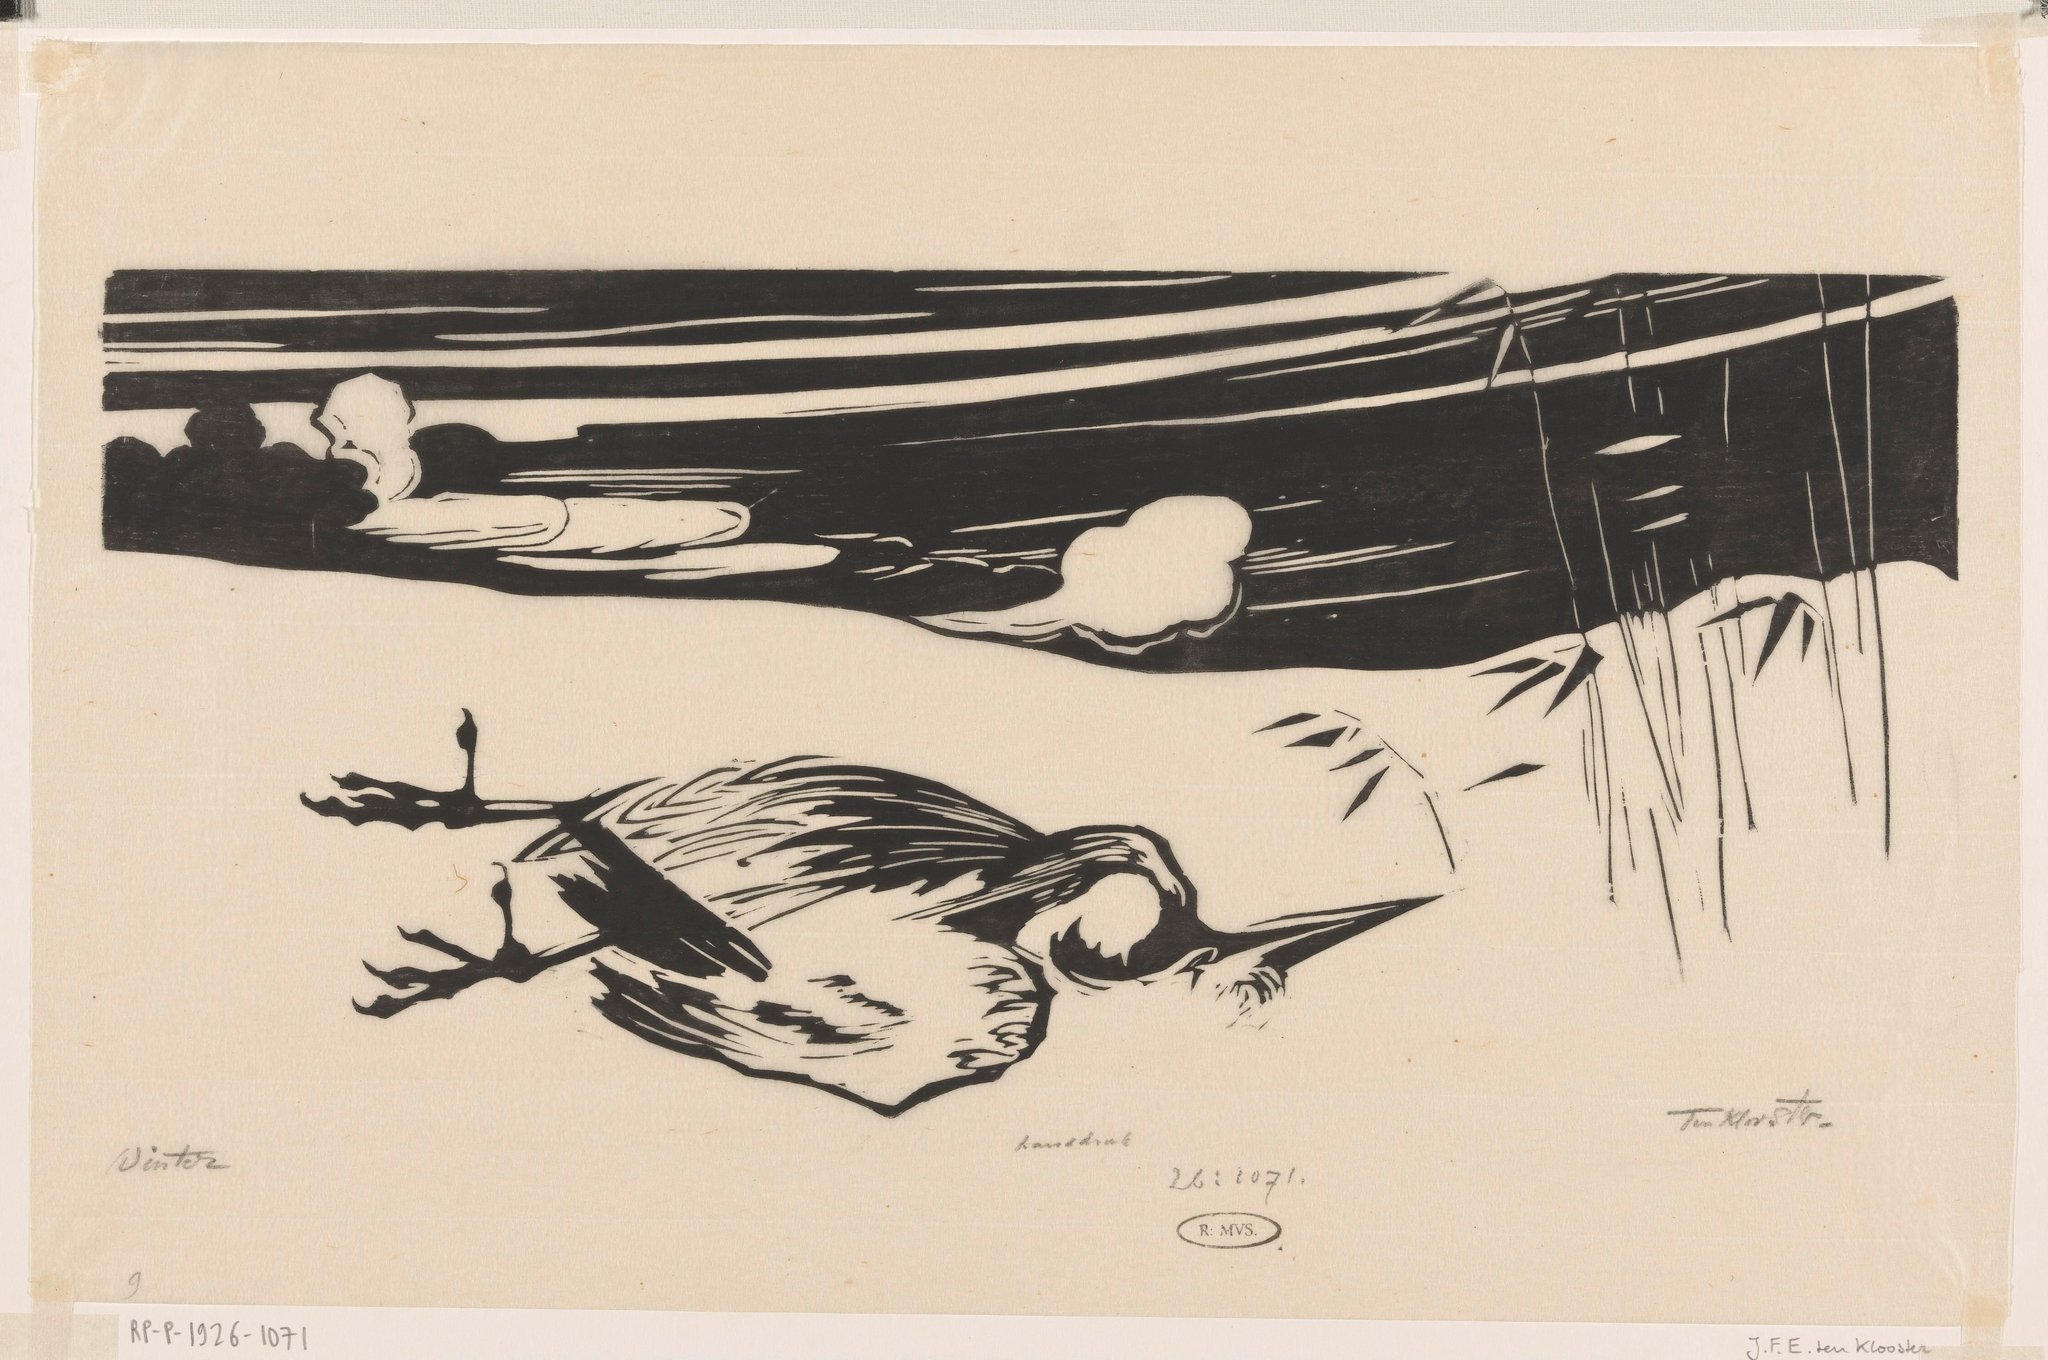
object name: print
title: Winter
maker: johannes frederik engelbert ten klooster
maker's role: draughtsman, print maker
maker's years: 1873-1940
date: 1926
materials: paper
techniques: woodcut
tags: shore-birds and wading-birds: heron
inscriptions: collector's mark: Lugt 2228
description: Een dode reiger, liggend op zijn rug, in een glooiend landschap met bamboehalmen.